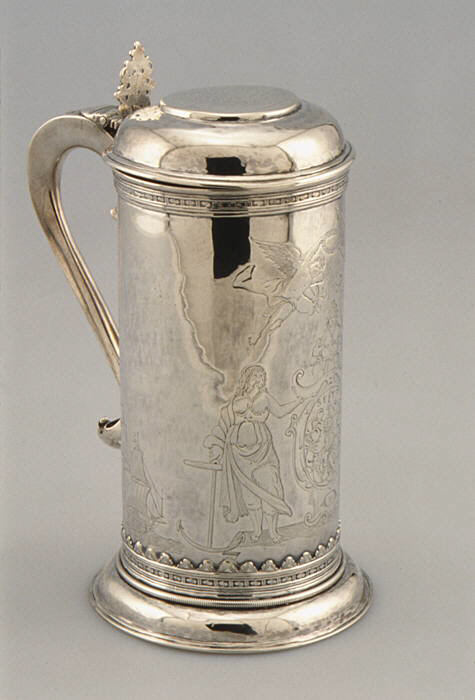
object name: flagon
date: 1679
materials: silver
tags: men,coat of arms